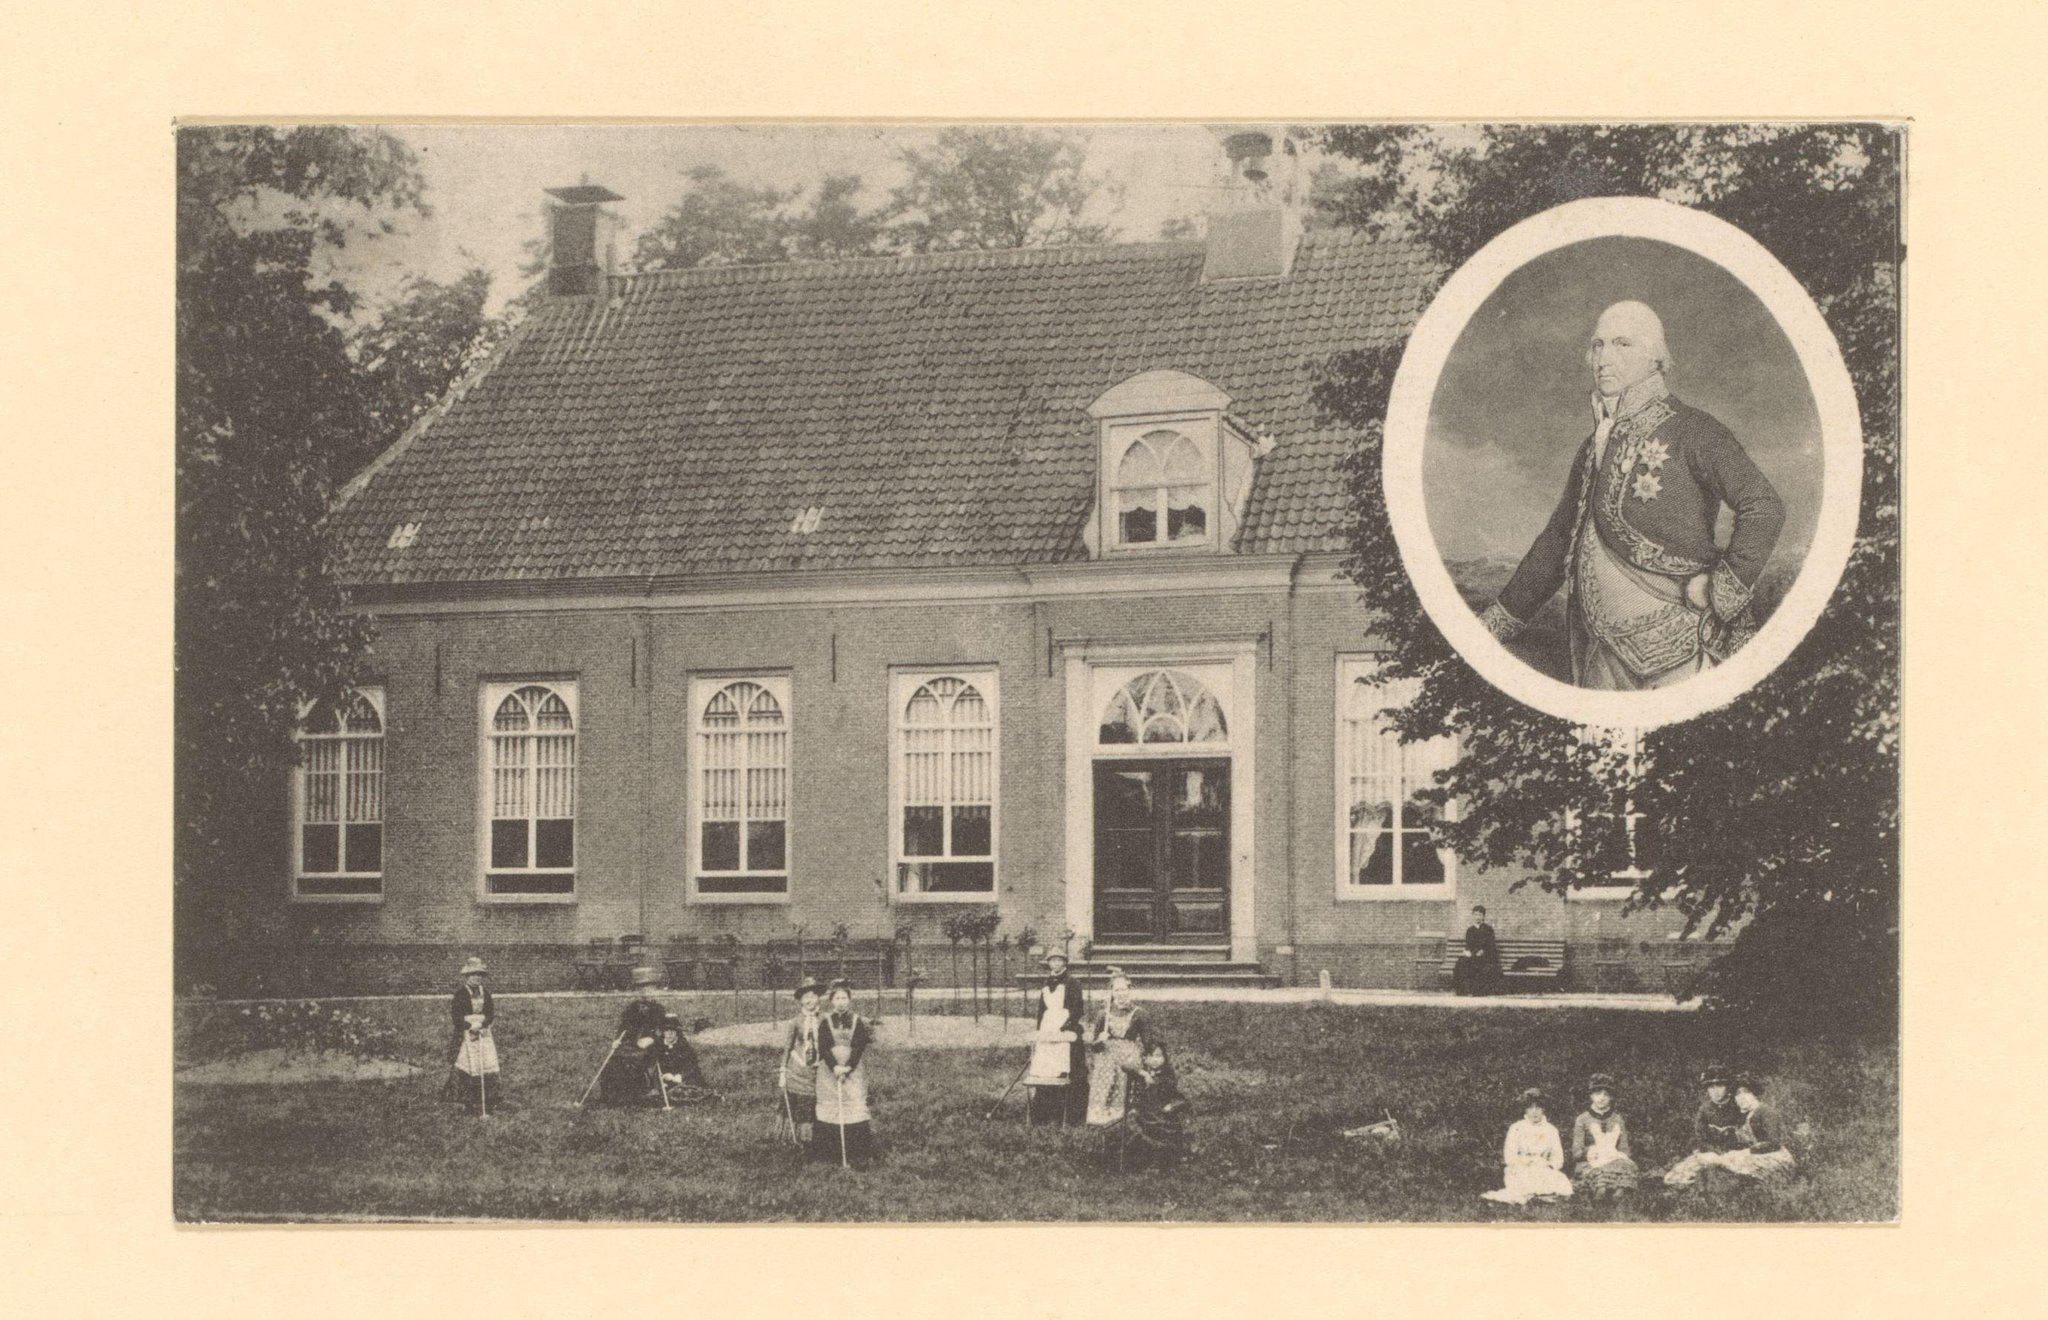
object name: ansichtkaart, prentbriefkaart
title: Gezicht op Huize Welgelegen te Apeldoorn met admiraal Jan Hendrik van Kinsbergen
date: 1880-1920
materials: cardboard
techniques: photograph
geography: apeldoorn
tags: jonkheer jan hendrik van kinsbergen, historical persons, villa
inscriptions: inscription: ‘1718. Huis "Welgelegen" in oorspronkelijken toestand met portret van den vroegeren bewoner, Admiraal Jhr. Jan Hendrik van Kinsbergen/ Uitg. G.J. Bosch v/h Frima A. Pull ter Gunne, Boekhandel. Apeldoorn.’